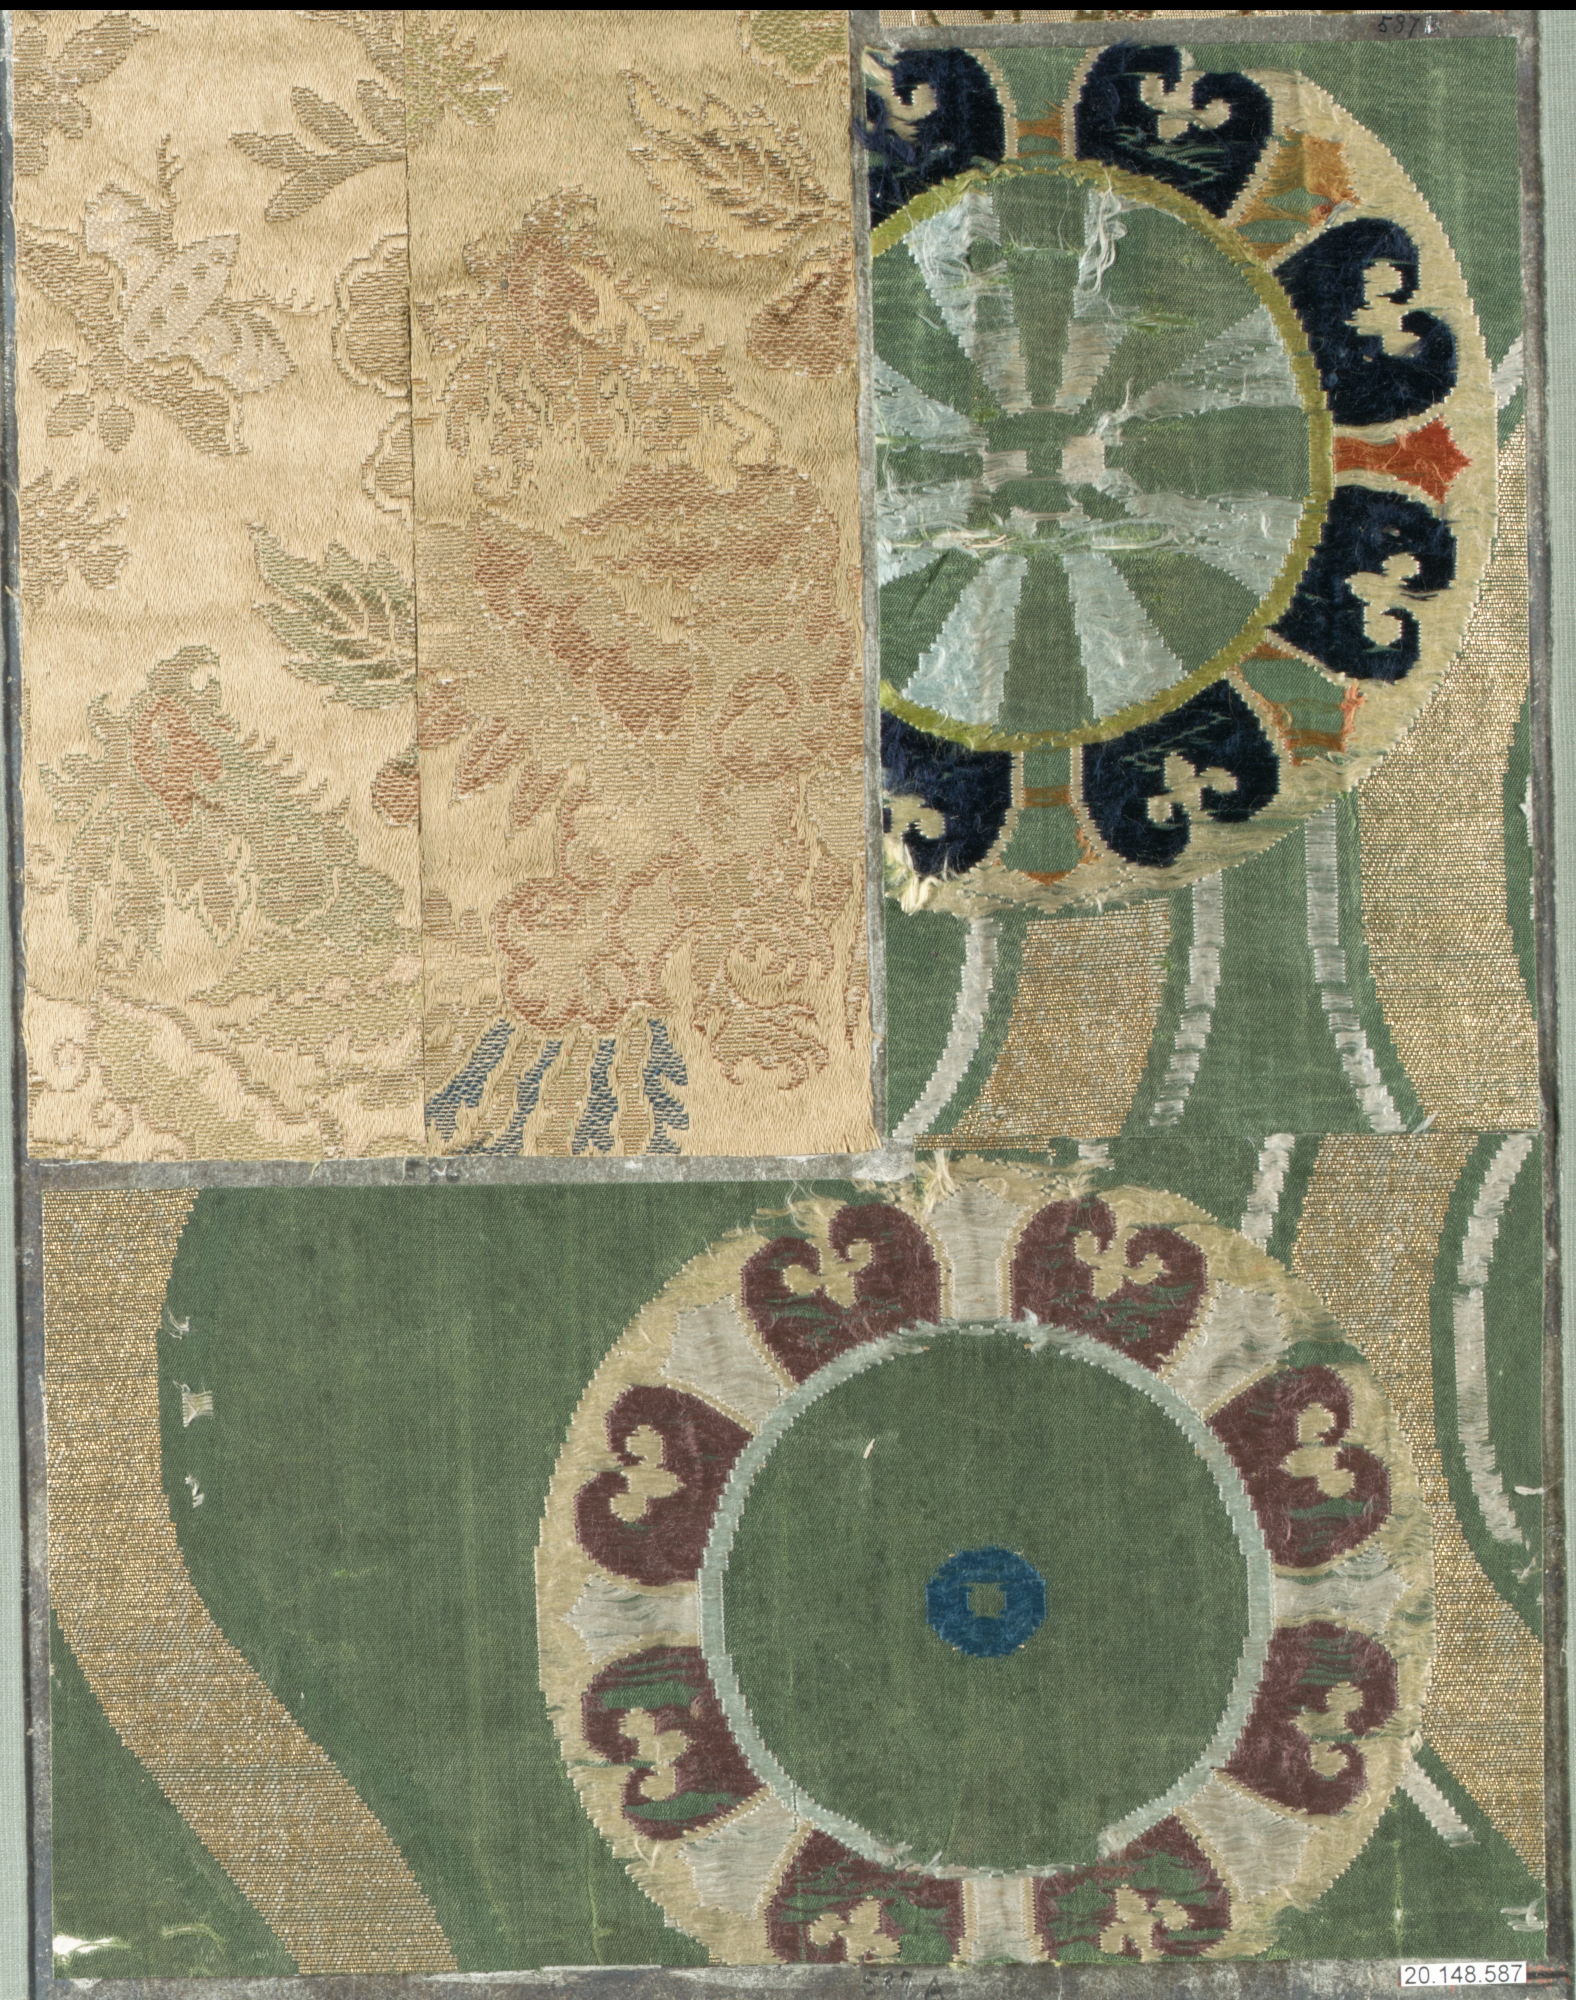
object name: brocade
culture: china or japan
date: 1701-1800